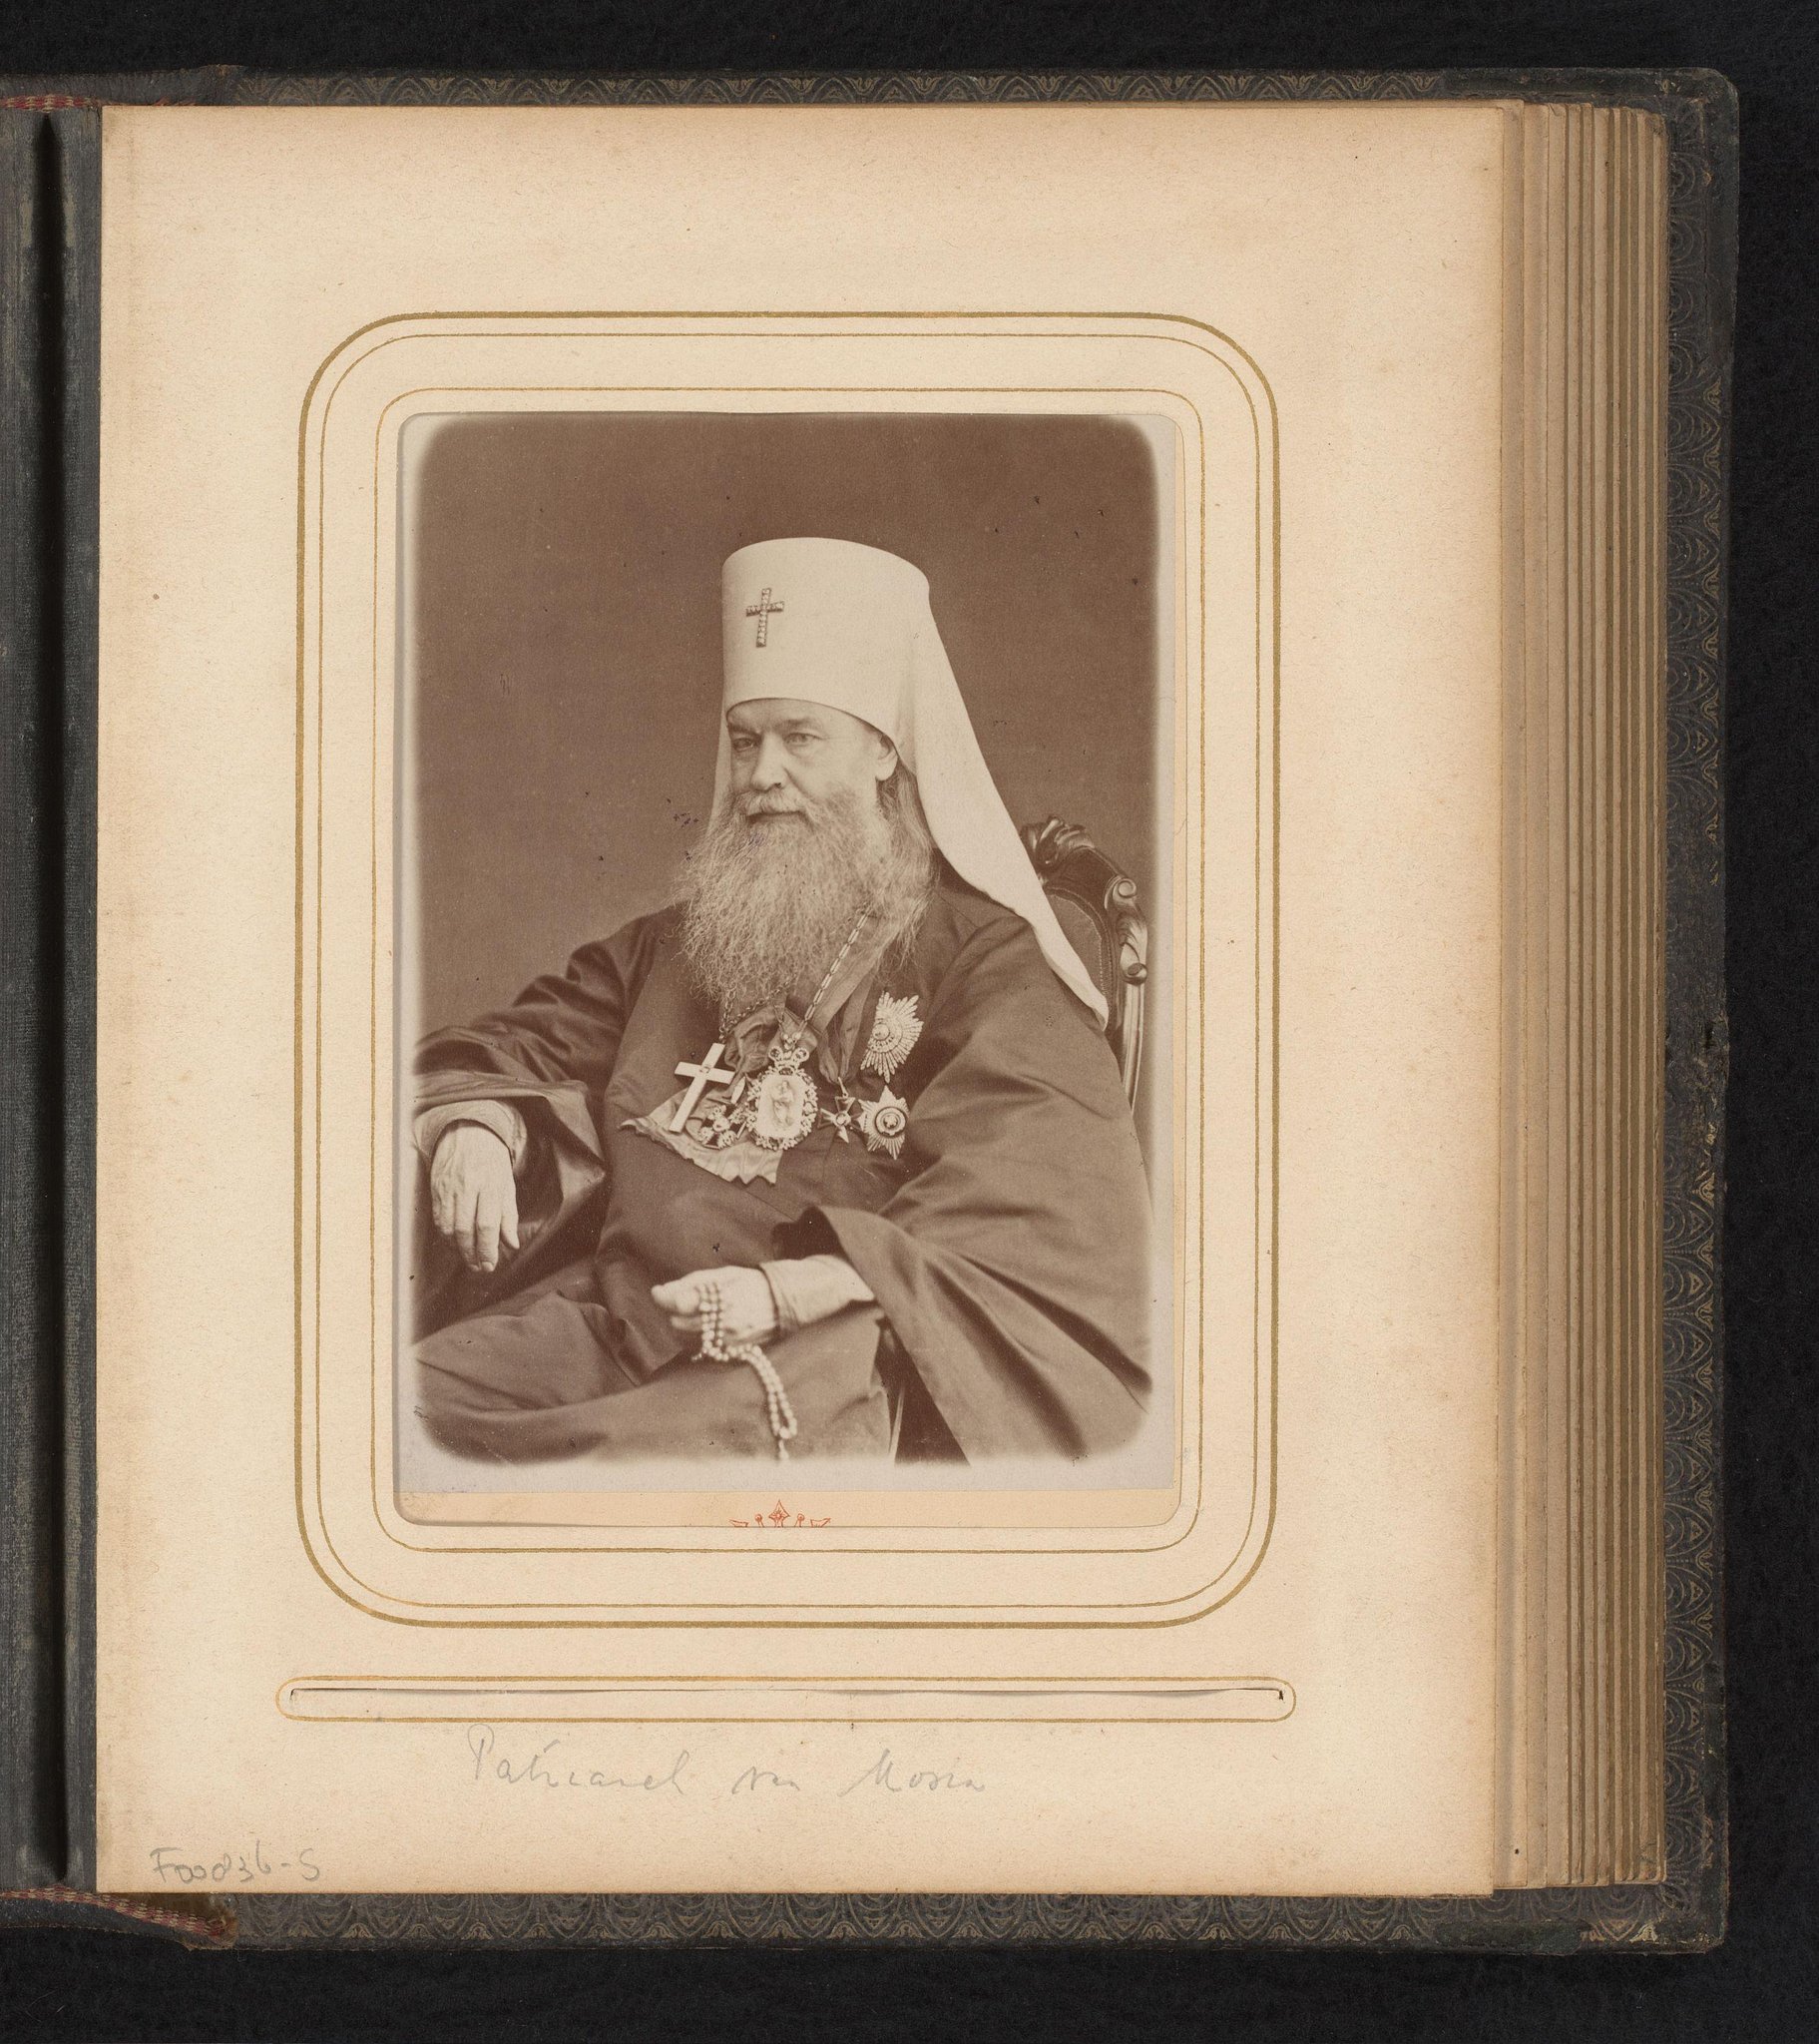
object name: album leaf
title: Portret van een Grieks-Orthodoxe priester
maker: Anonymous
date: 1870-1900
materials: cardboard, photographic support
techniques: albumen print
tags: greek orthodox church, historical persons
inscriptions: annotation: ‘Patriarch van Mosea’, annotation: ‘Patriarch de Mosea’